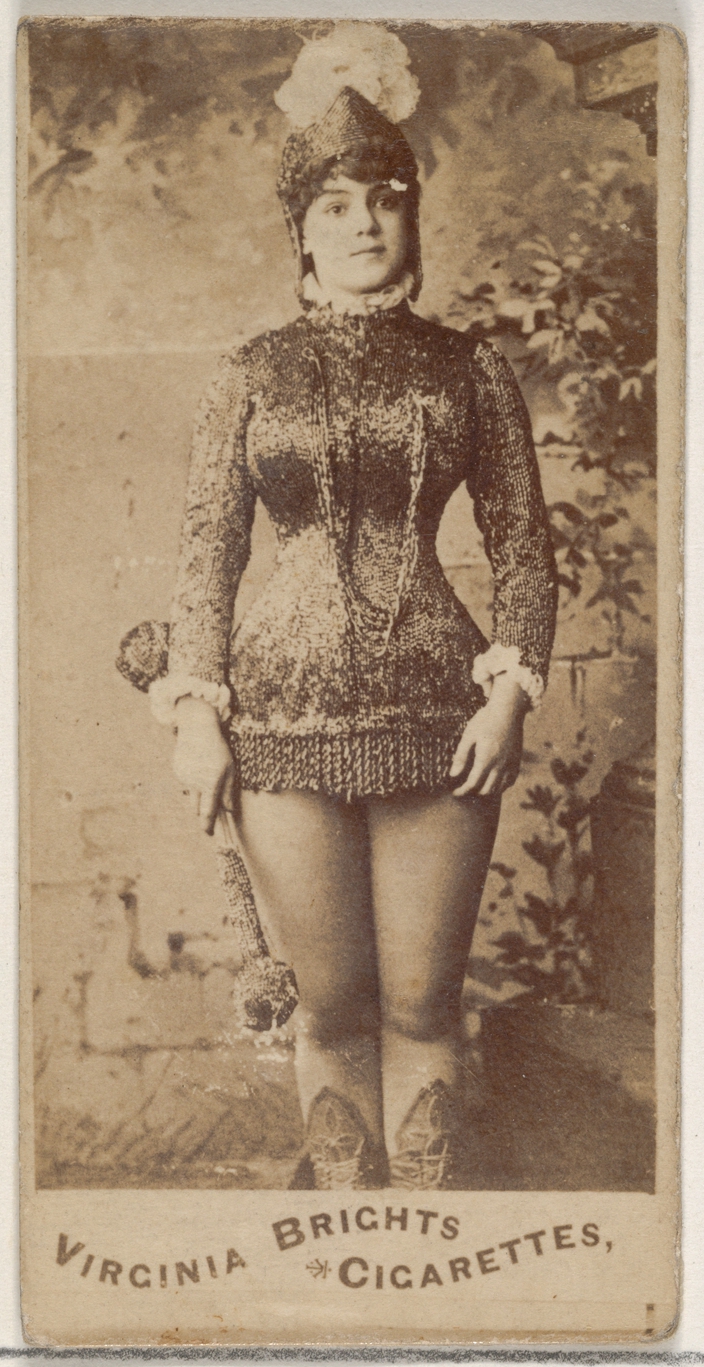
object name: photograph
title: From the Actors and Actresses series (N45, Type 5) for Virginia Brights Cigarettes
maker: allen & ginter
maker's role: publisher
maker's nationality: american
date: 1888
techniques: albumen silver print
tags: portraits,women,actresses